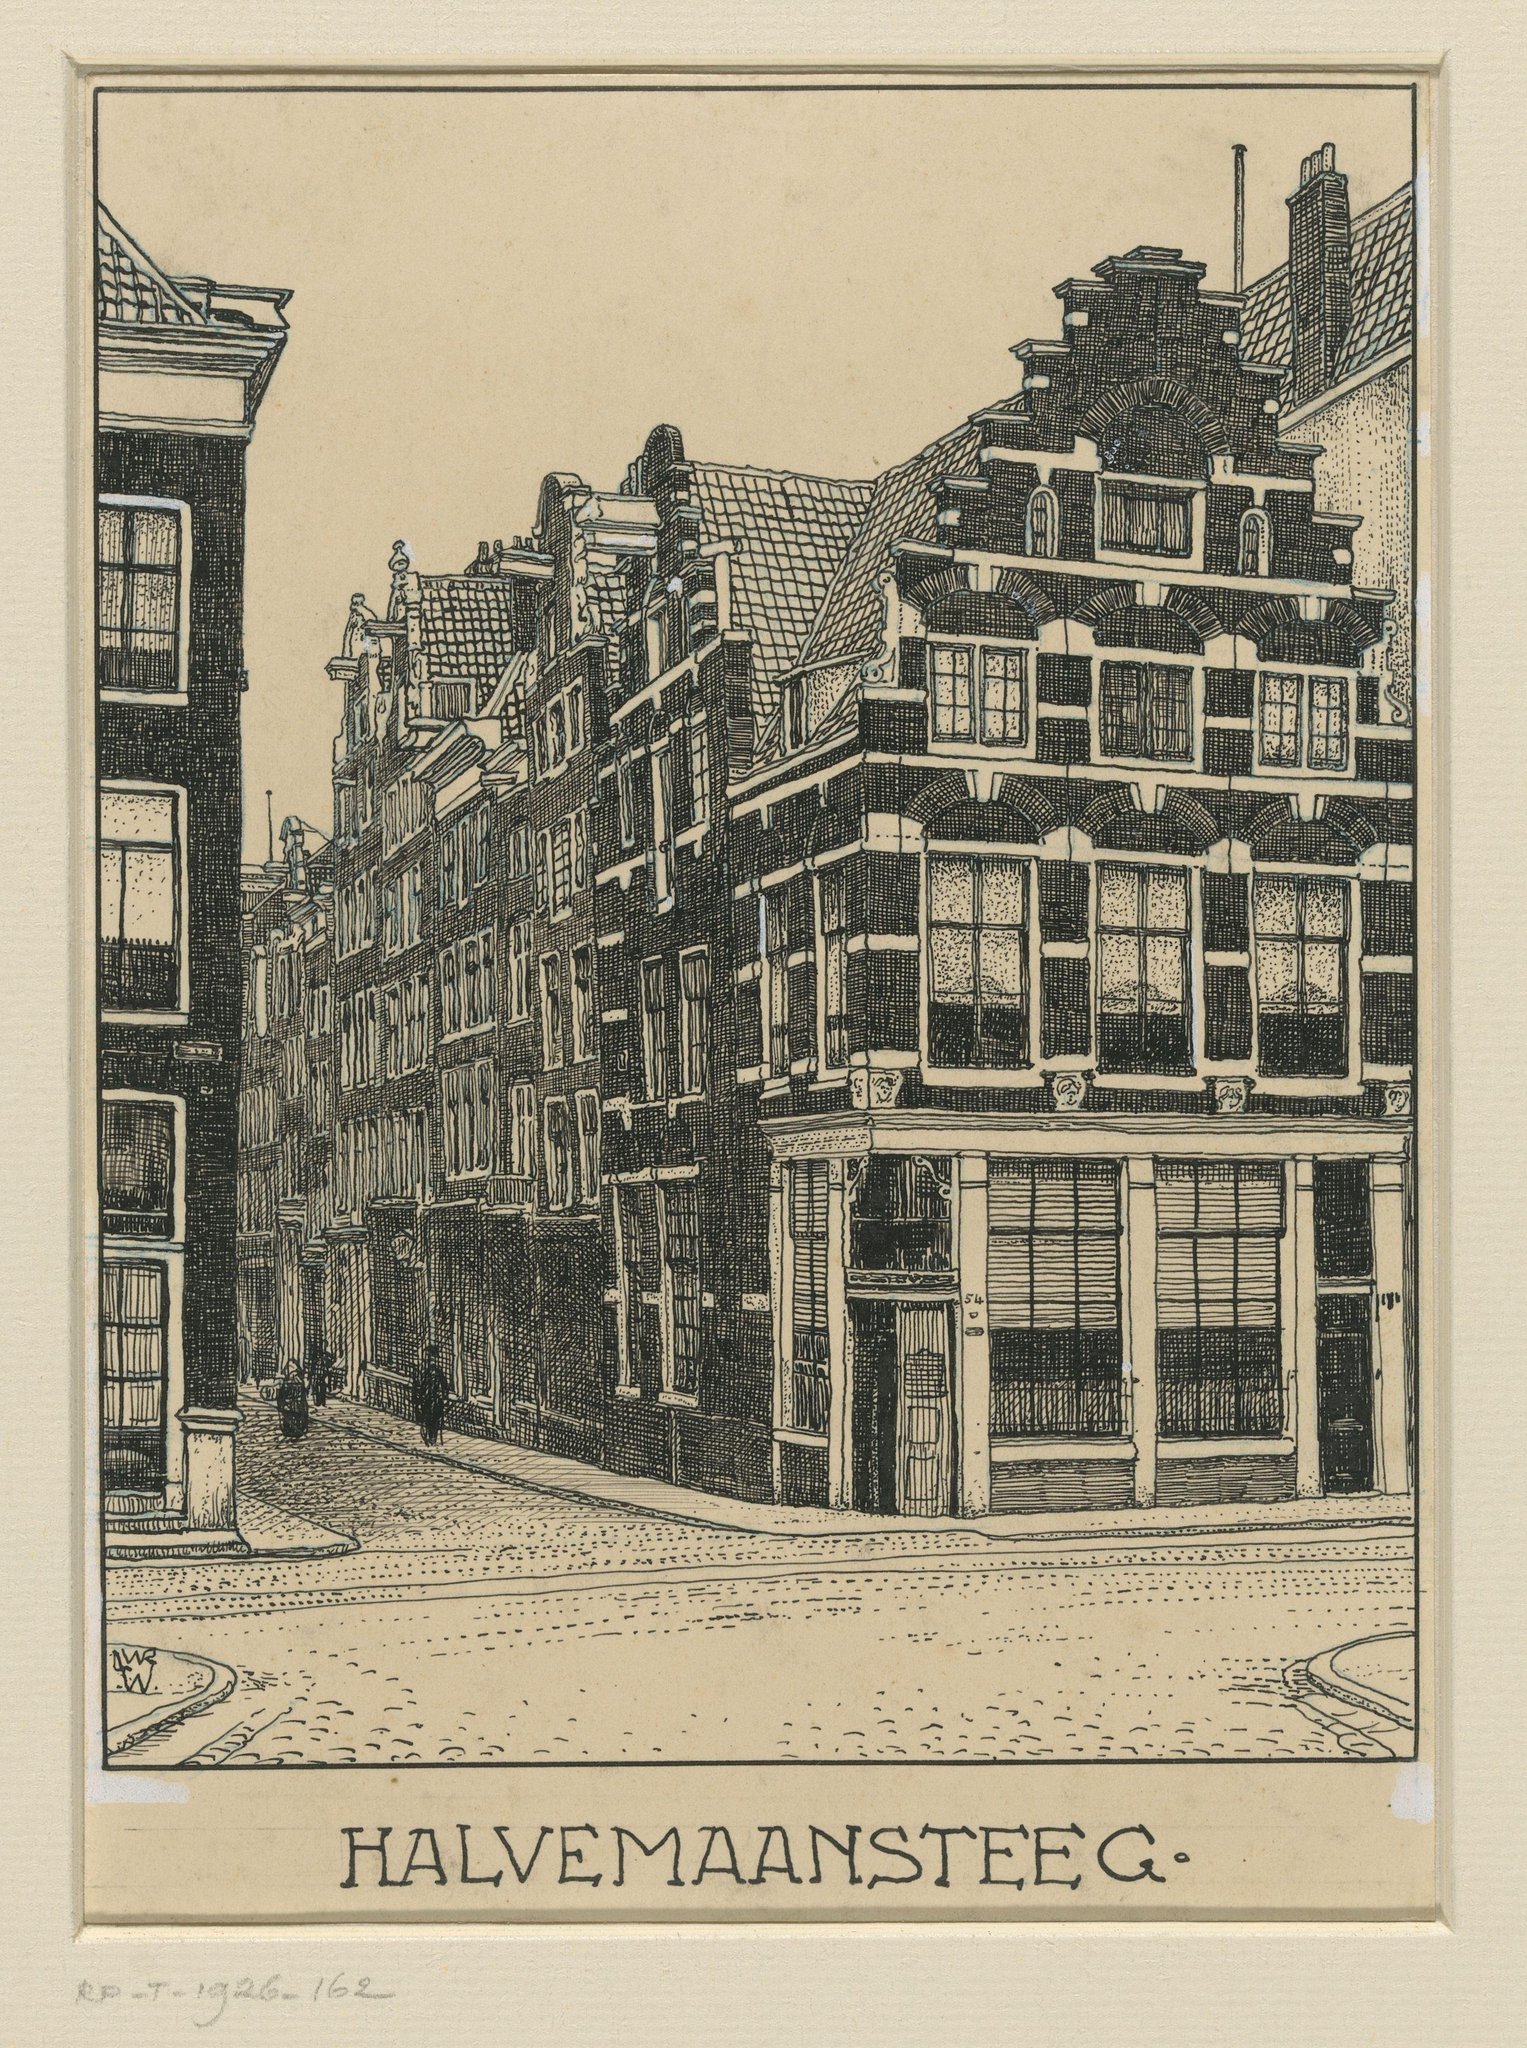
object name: drawing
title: Halvemaansteeg te Amsterdam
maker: willem wenckebach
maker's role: designer, draughtsman, painter, print maker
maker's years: 1860-1937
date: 1870-1926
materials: paint, ink, paper, pencil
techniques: pen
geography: amsterdam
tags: lane, alley